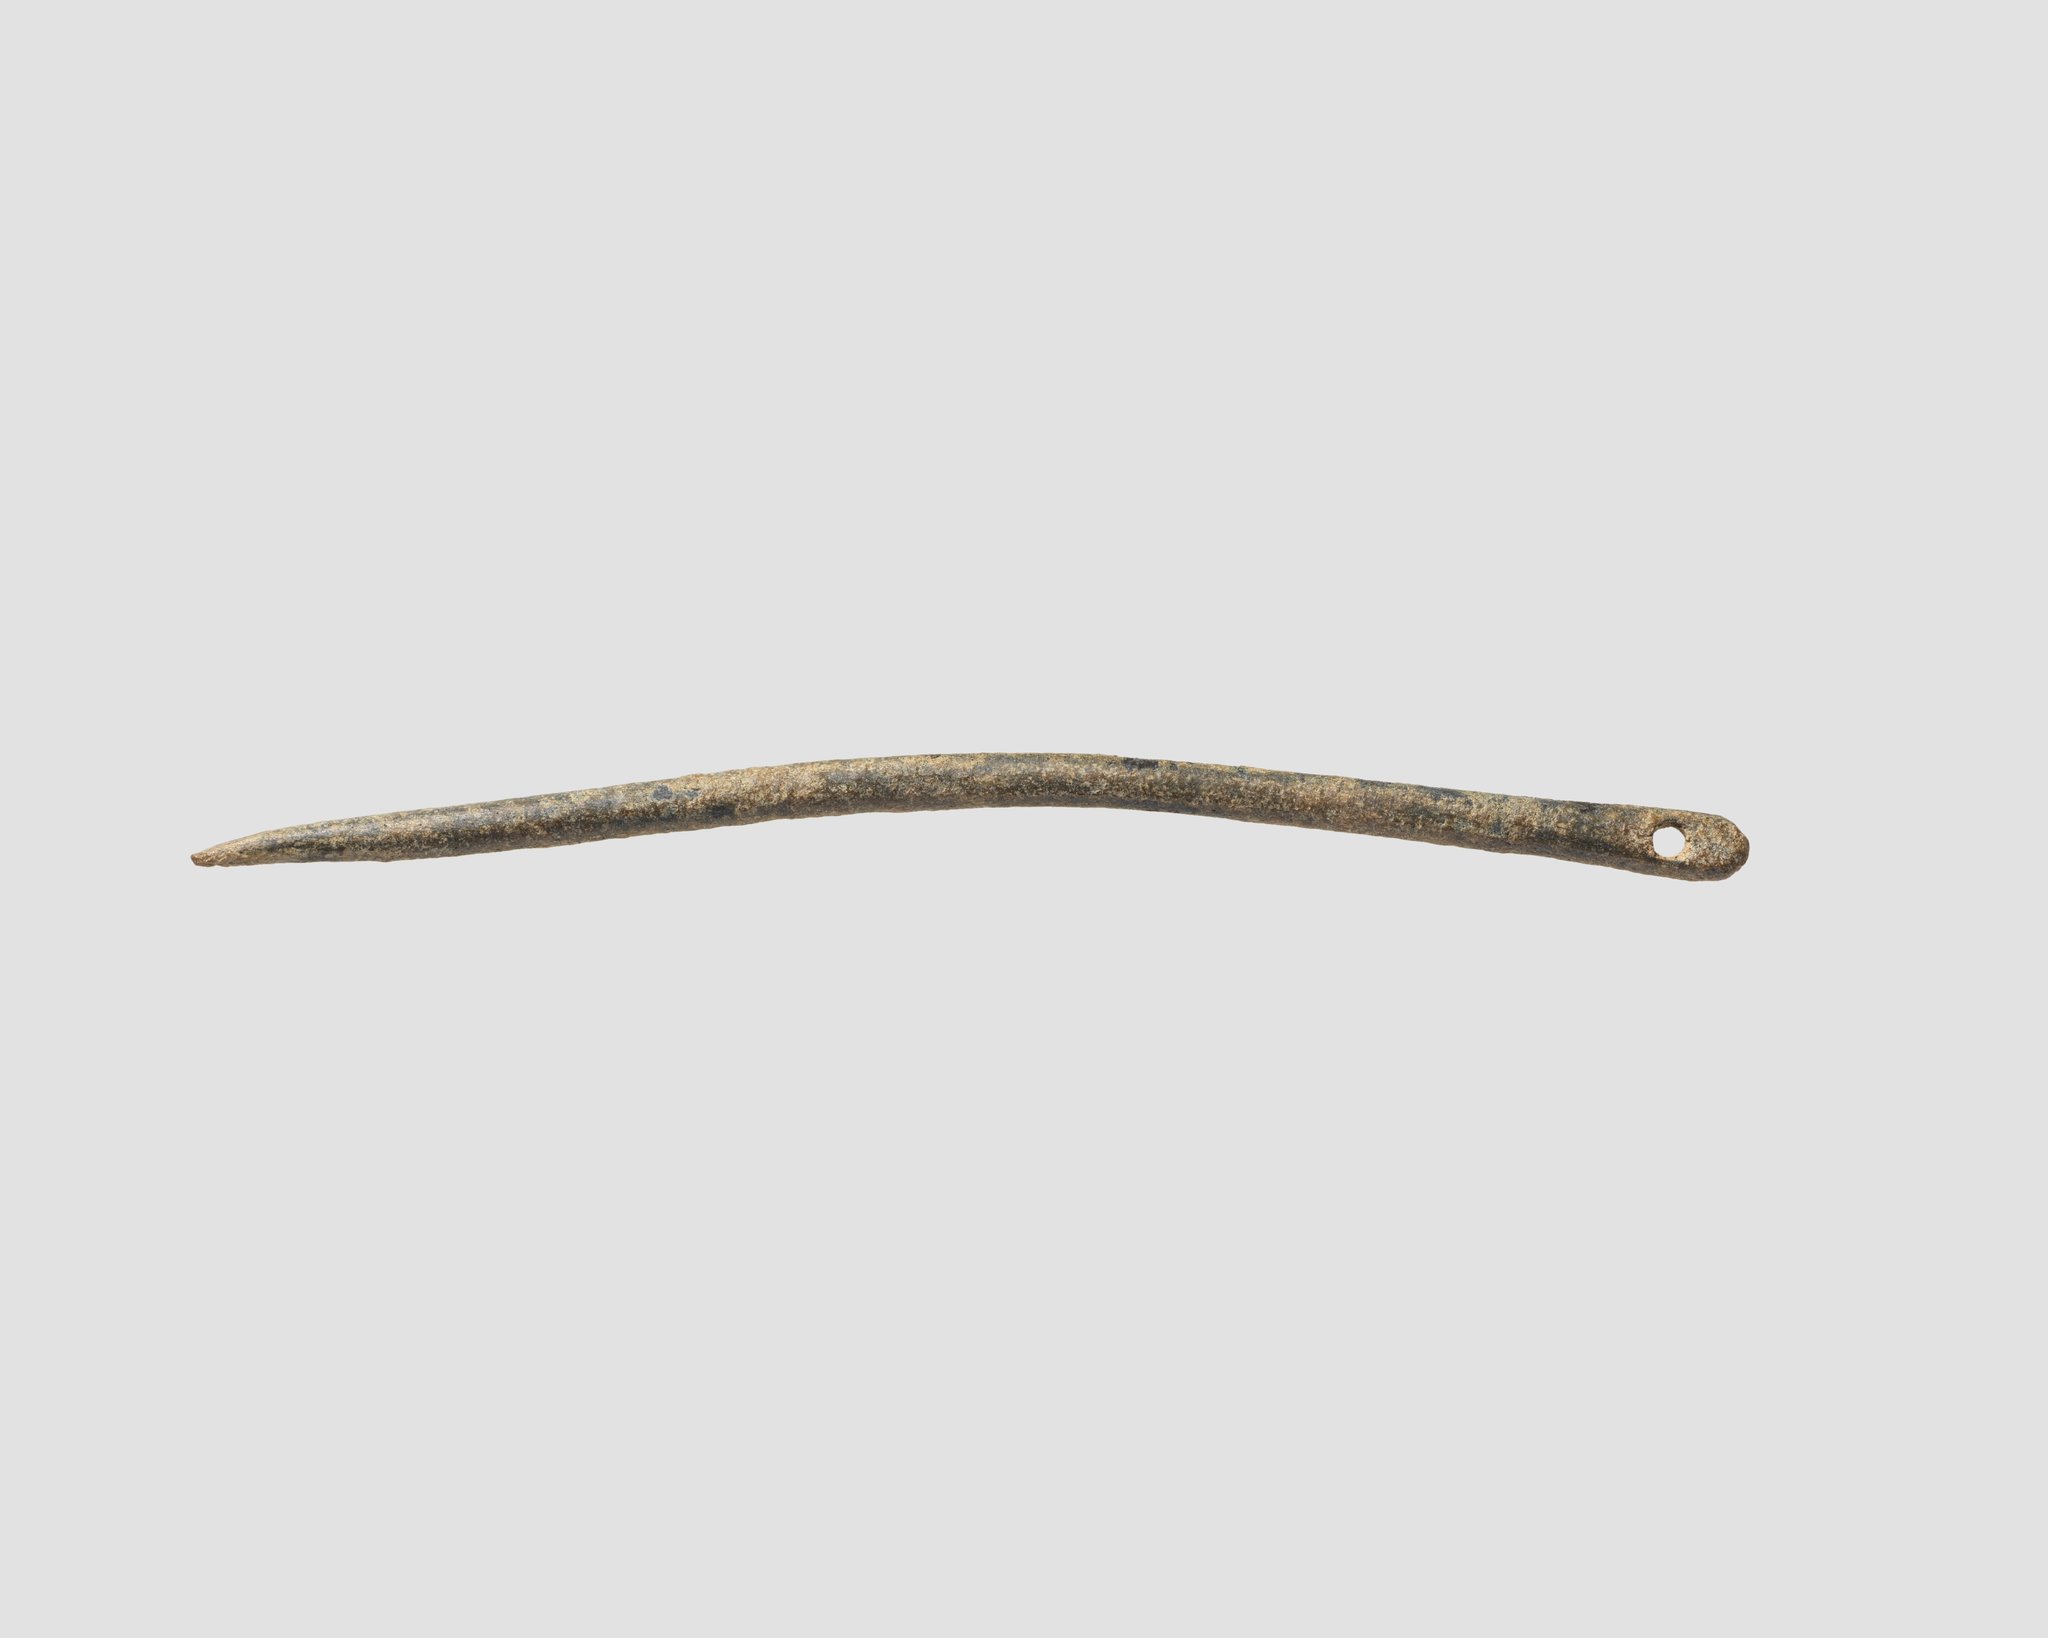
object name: needle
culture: sasanian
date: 201-700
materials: bronze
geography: iran